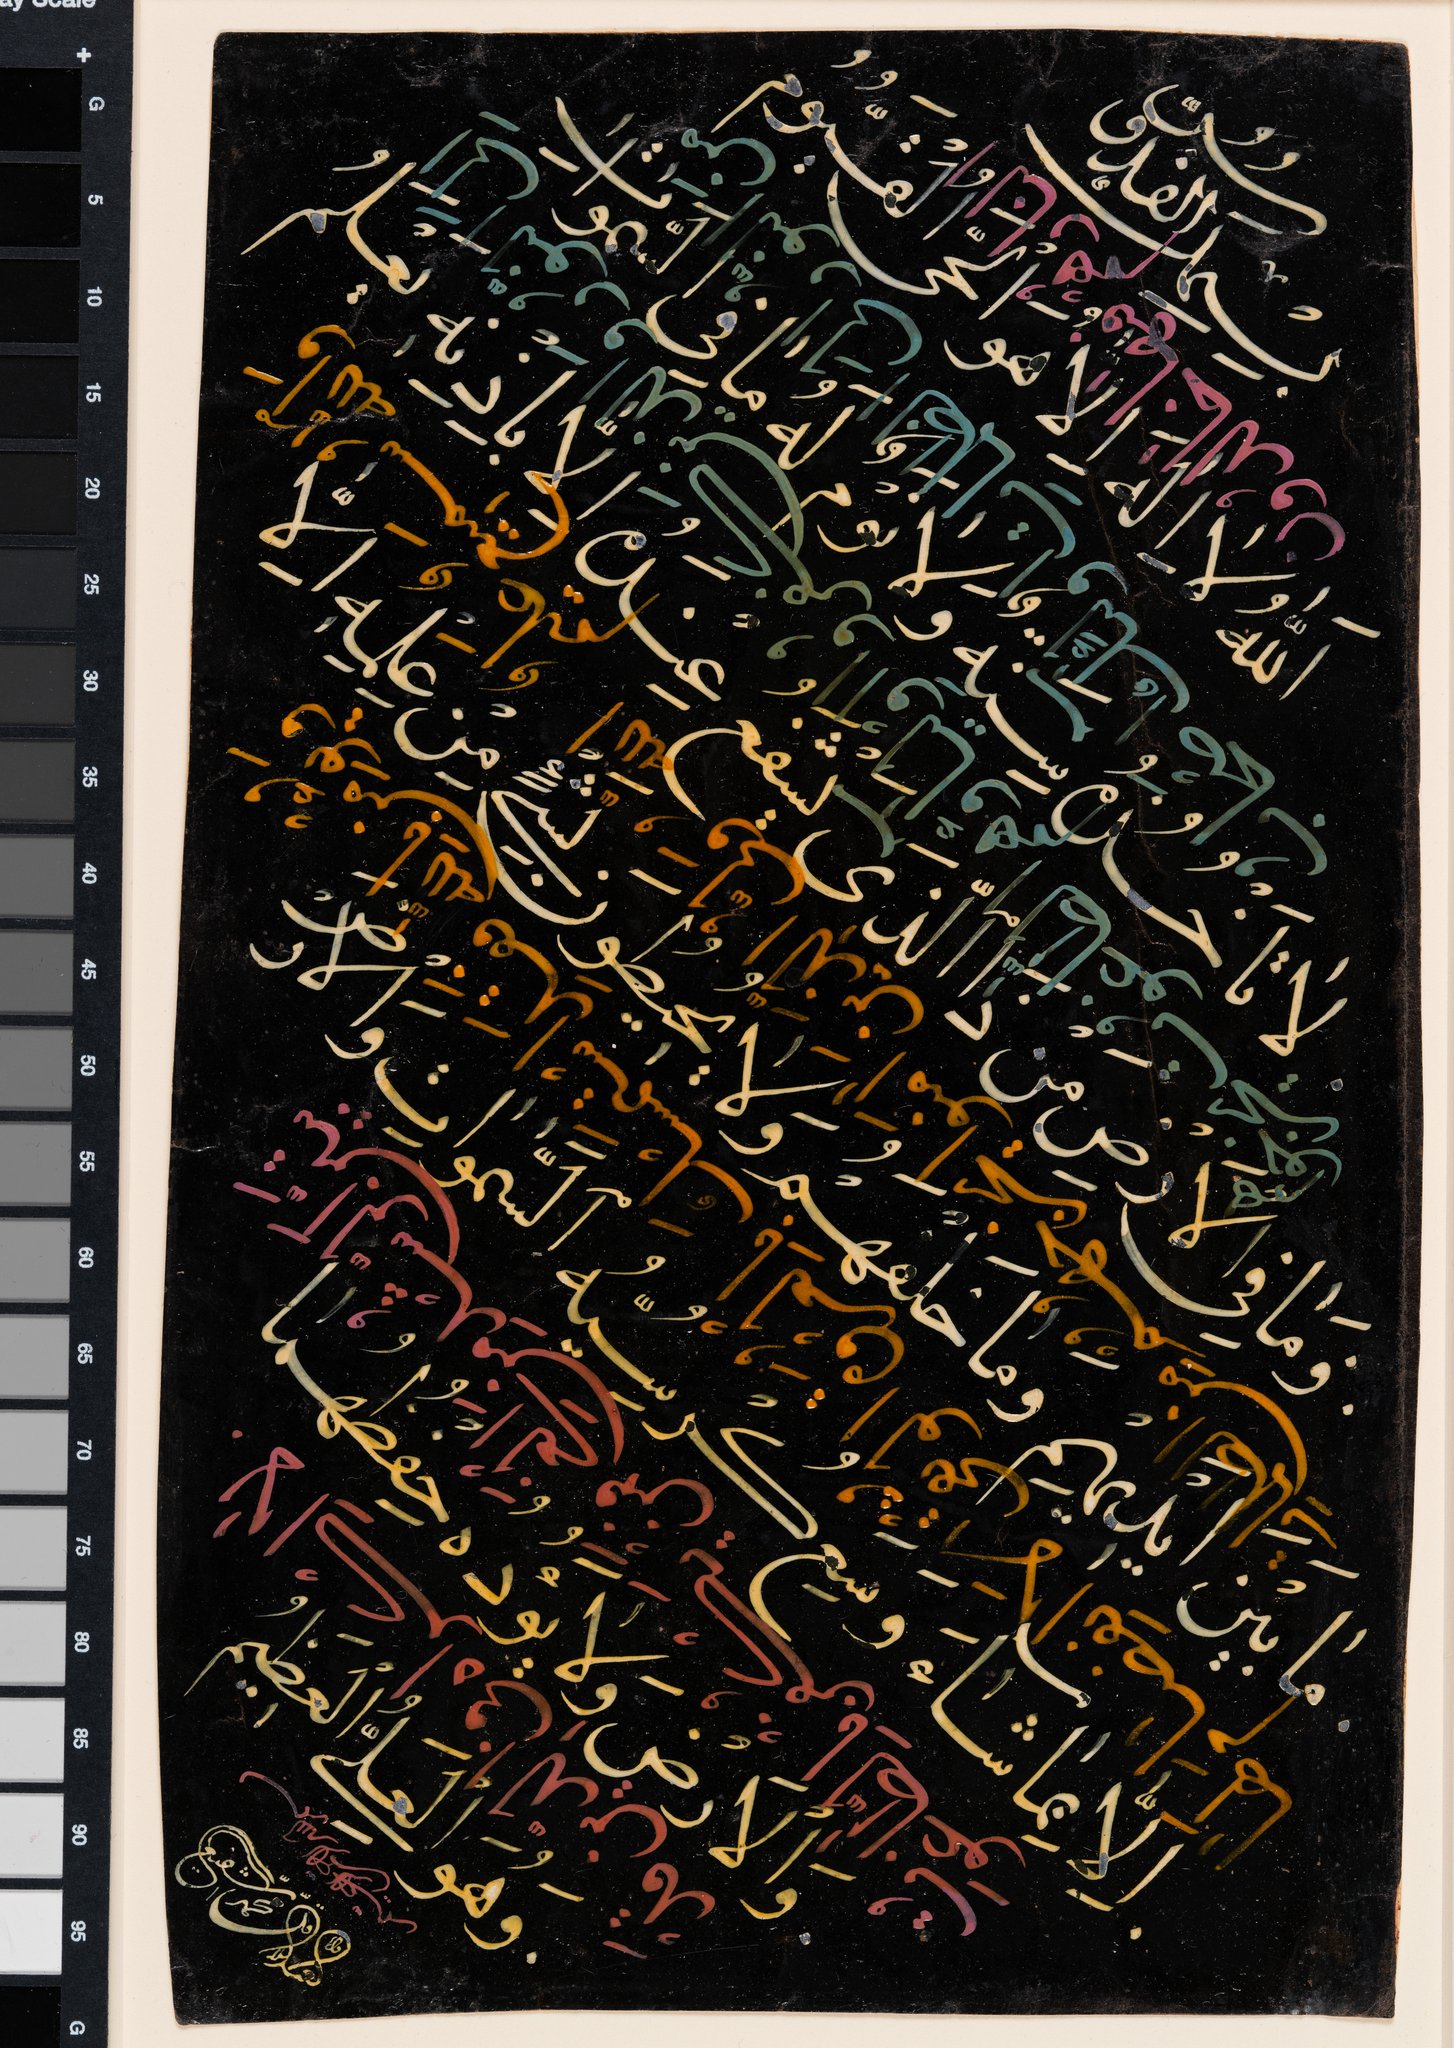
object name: non illustrated album leaf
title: Page of Calligraphy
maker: muhammad shafi‘ known as vesal-i shirazi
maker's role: calligrapher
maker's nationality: iranian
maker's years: 1779-1846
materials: gold, ink, paper, watercolor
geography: iran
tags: calligraphy